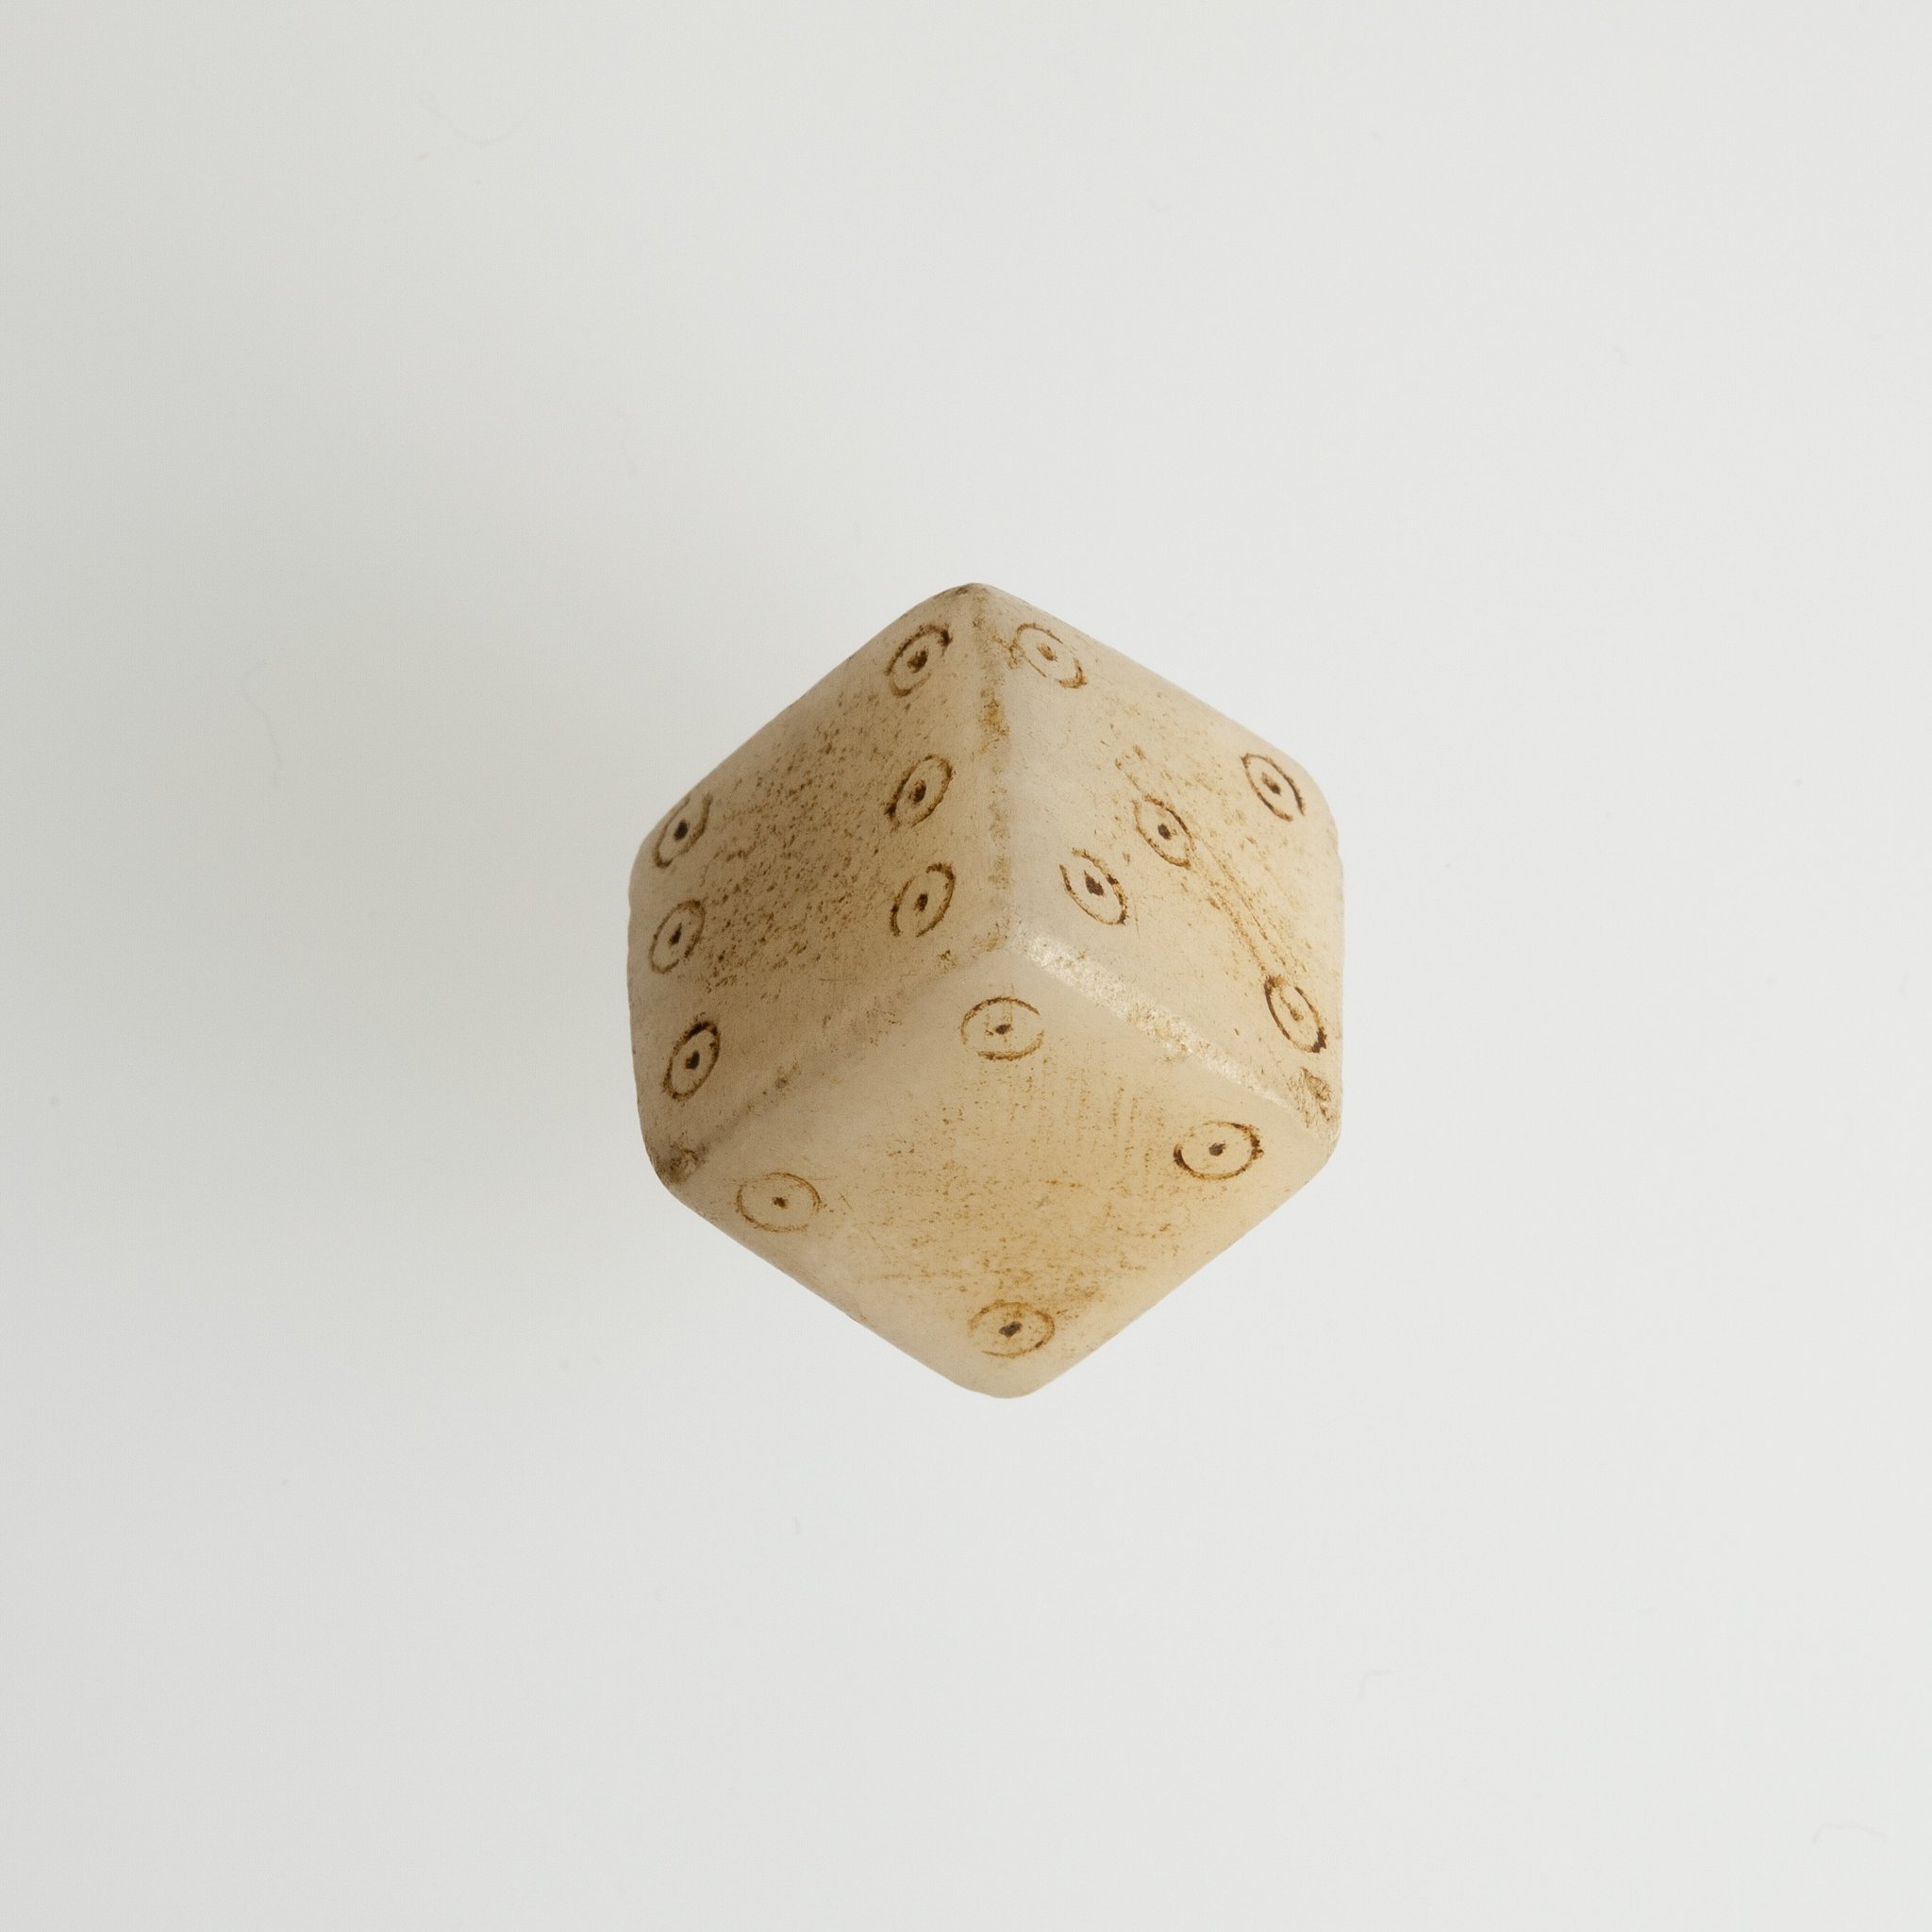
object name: die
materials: stone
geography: egypt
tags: dice